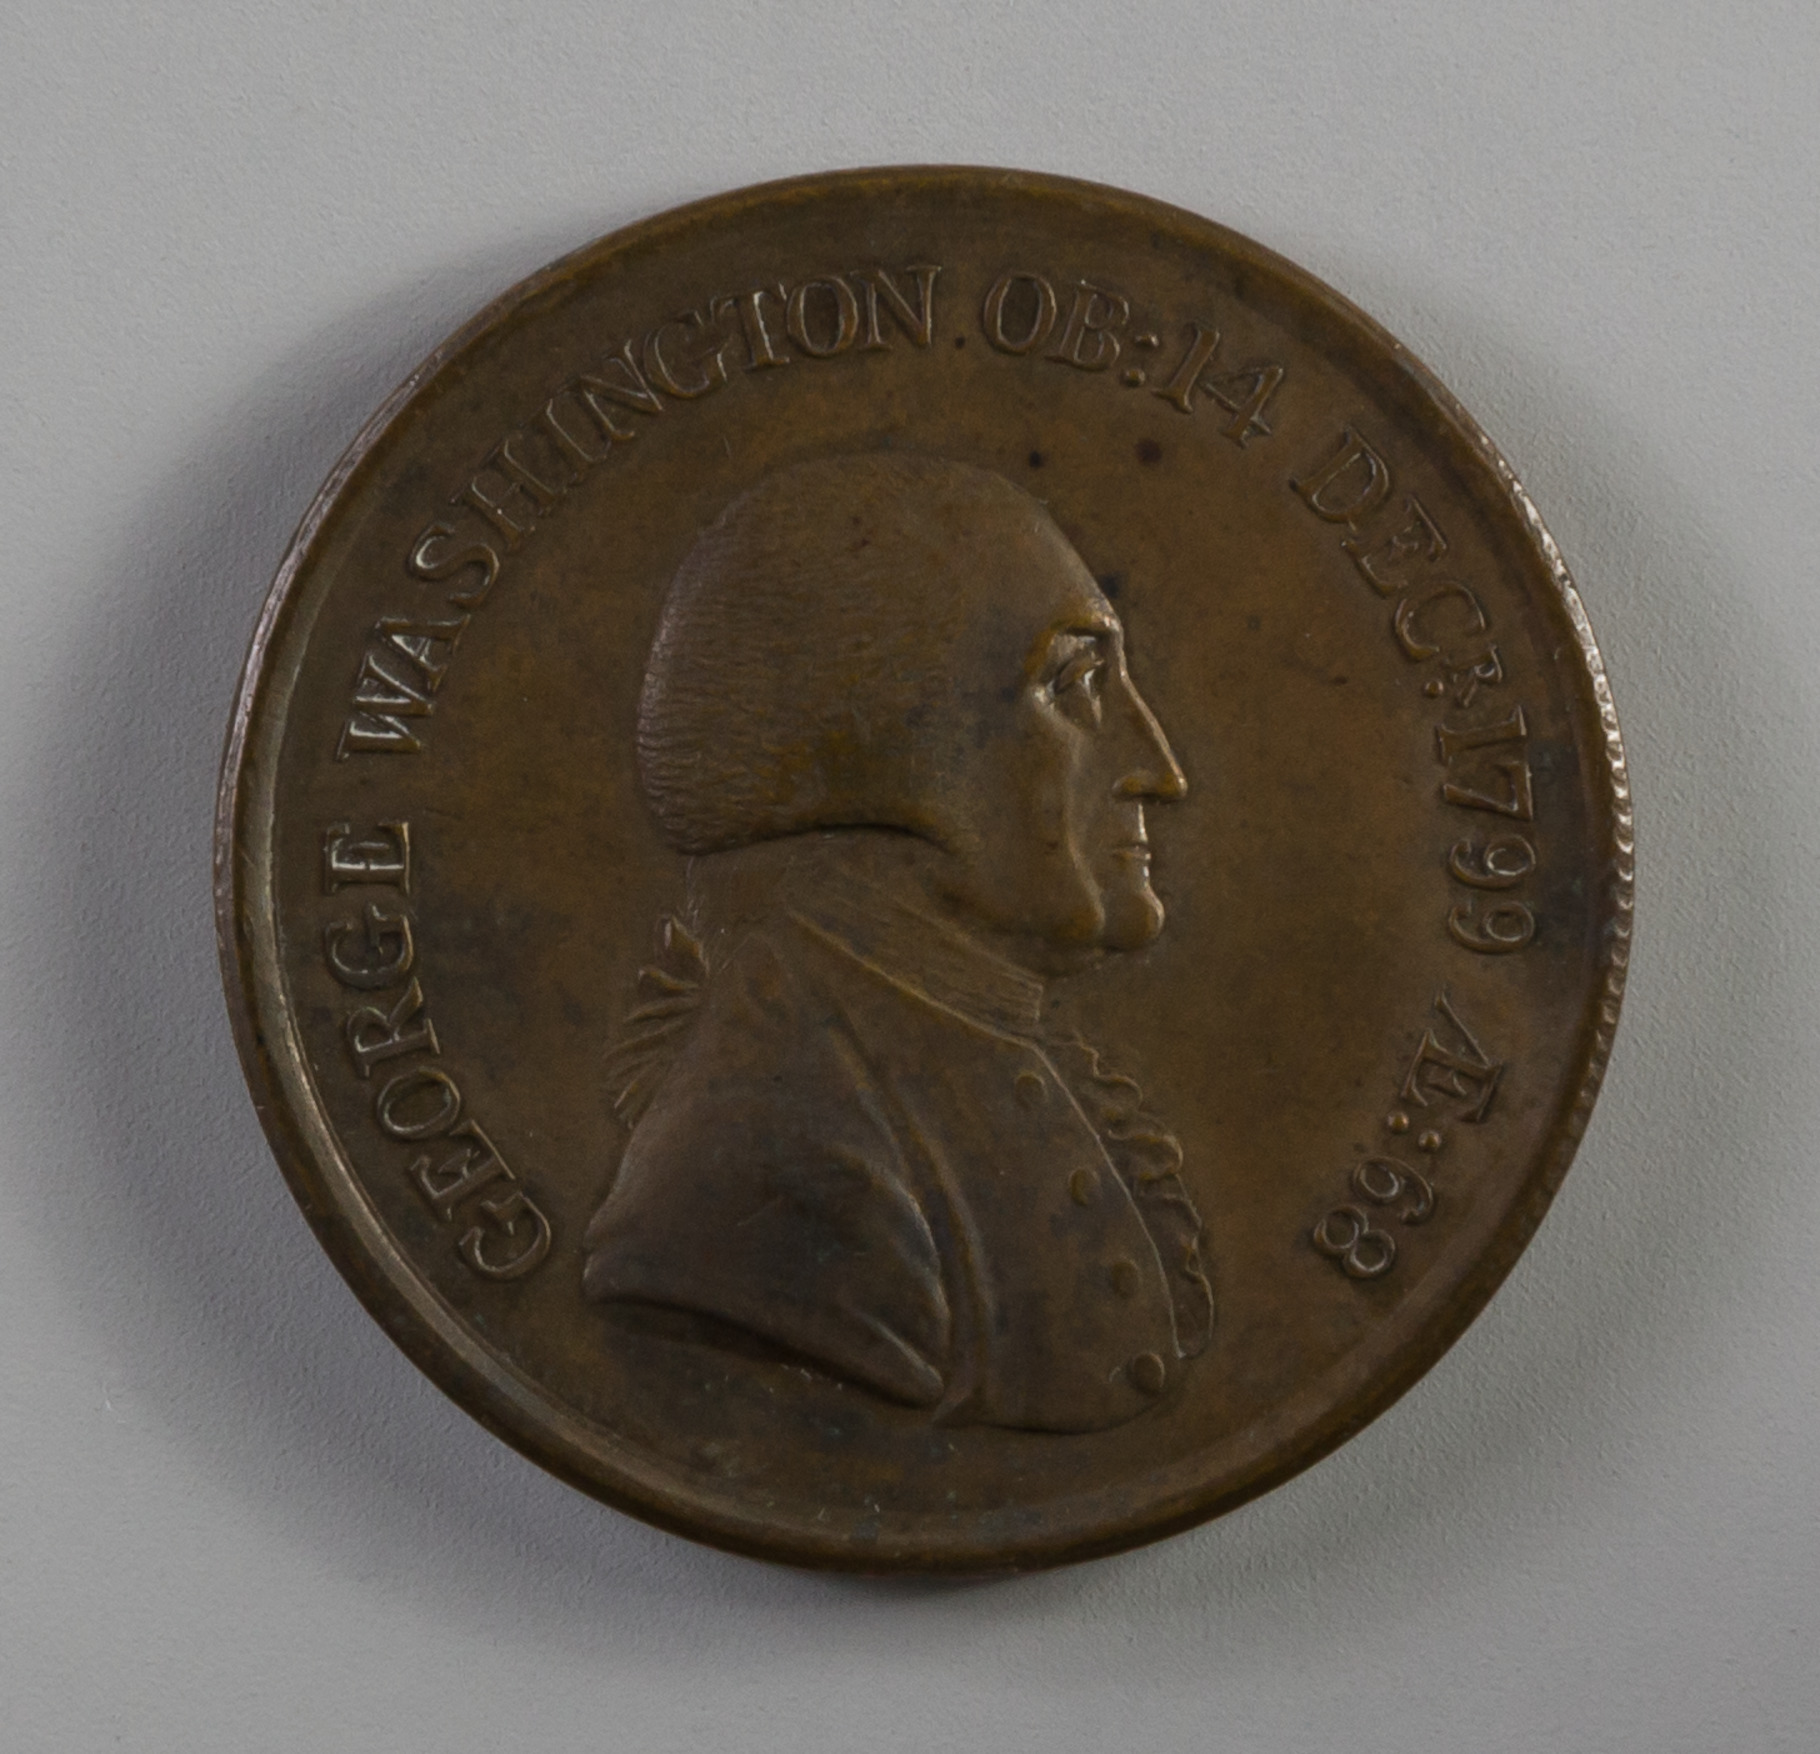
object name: medal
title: Medal Commemorating the Death of George Washington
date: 1800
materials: bronze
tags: george washington,profiles